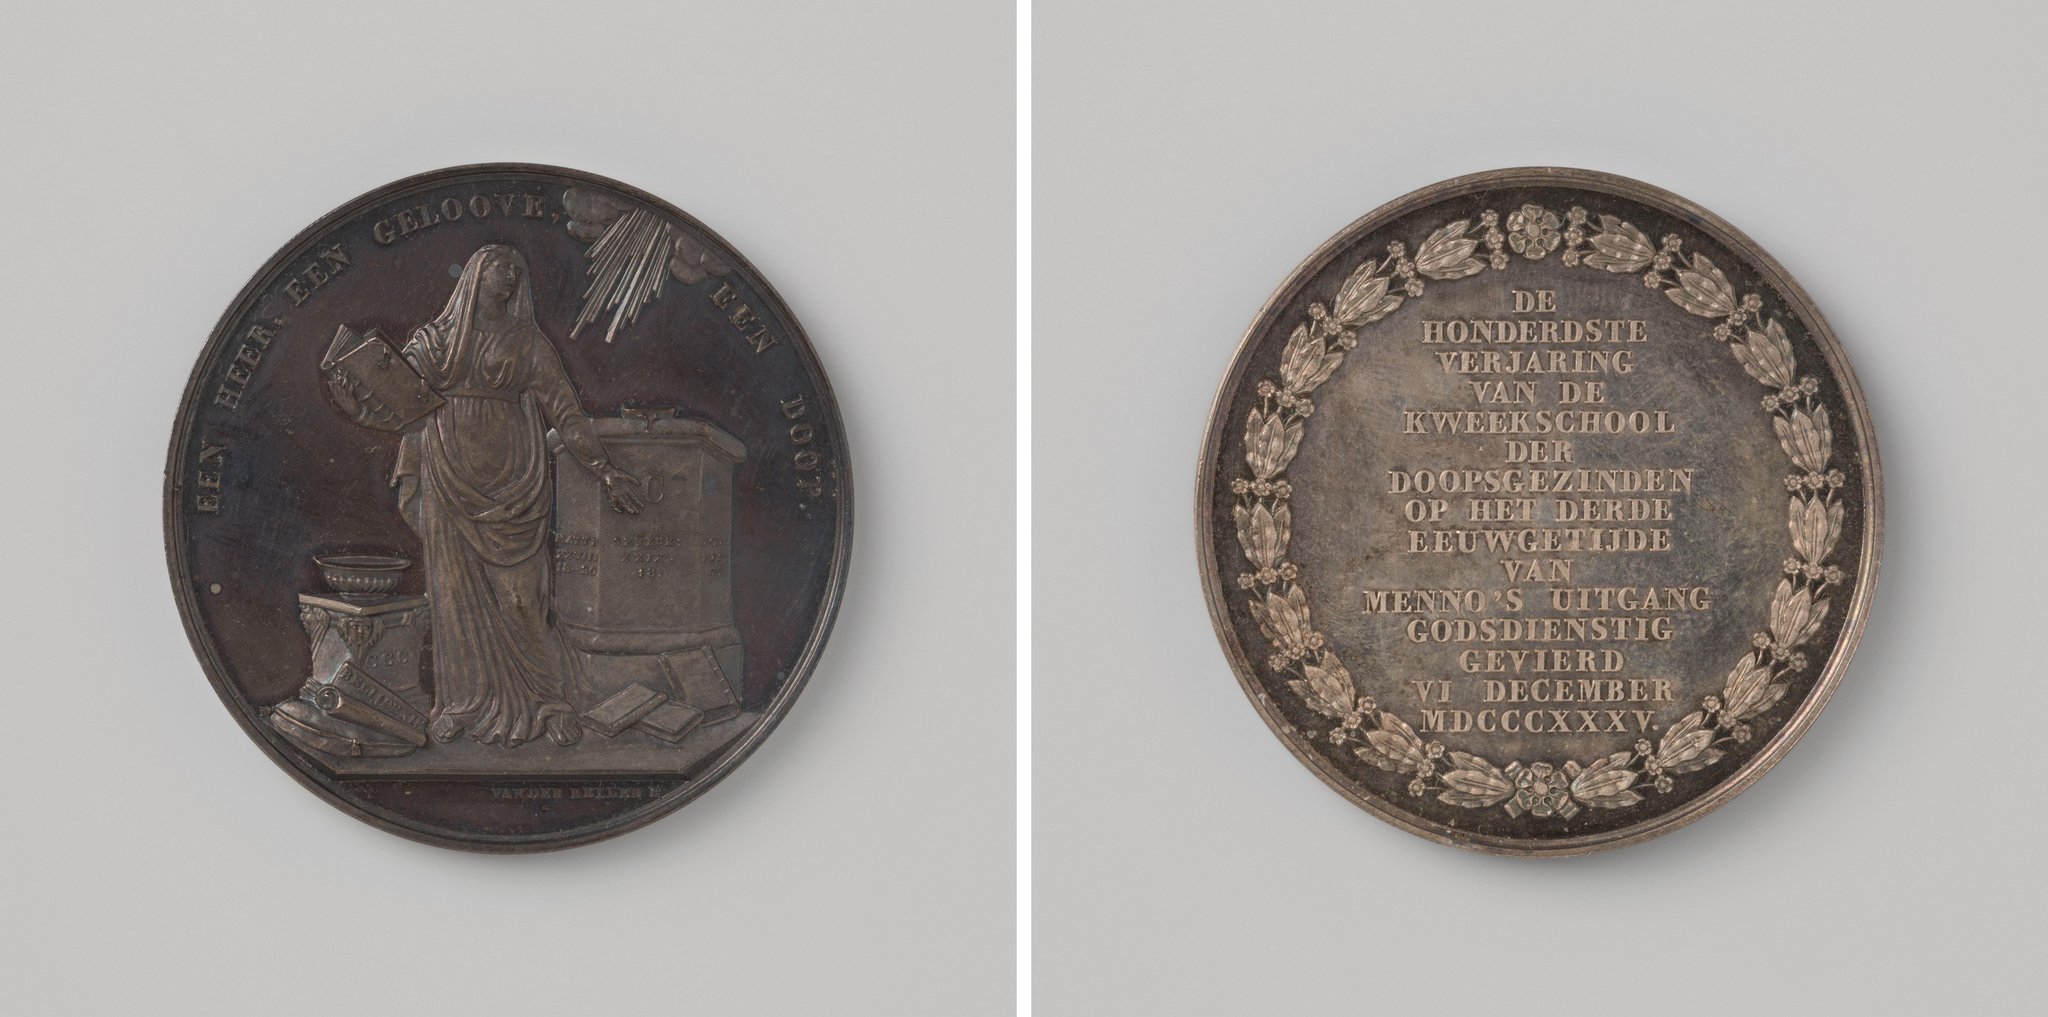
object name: history medal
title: Honderdjarig bestaan van de Kweekschool der Doopsgezinden te Amsterdam 1835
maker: david van der kellen (1804-1879)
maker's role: die cutter, draughtsman, print maker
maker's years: 1804-1879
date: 1835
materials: silver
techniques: striking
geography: utrecht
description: Zilveren penning, op de voorzijde een gesluierde vrouw met bijbel, beschenen vanuit de hemel, met de rechterhand wijzend op drie boeken naast een altaar, links een doopbekken op een voetstuk waarvoor een document op een kussen, met omschrift, op de keerzijde vijftien regels tekst binnen een mirtenkrans.